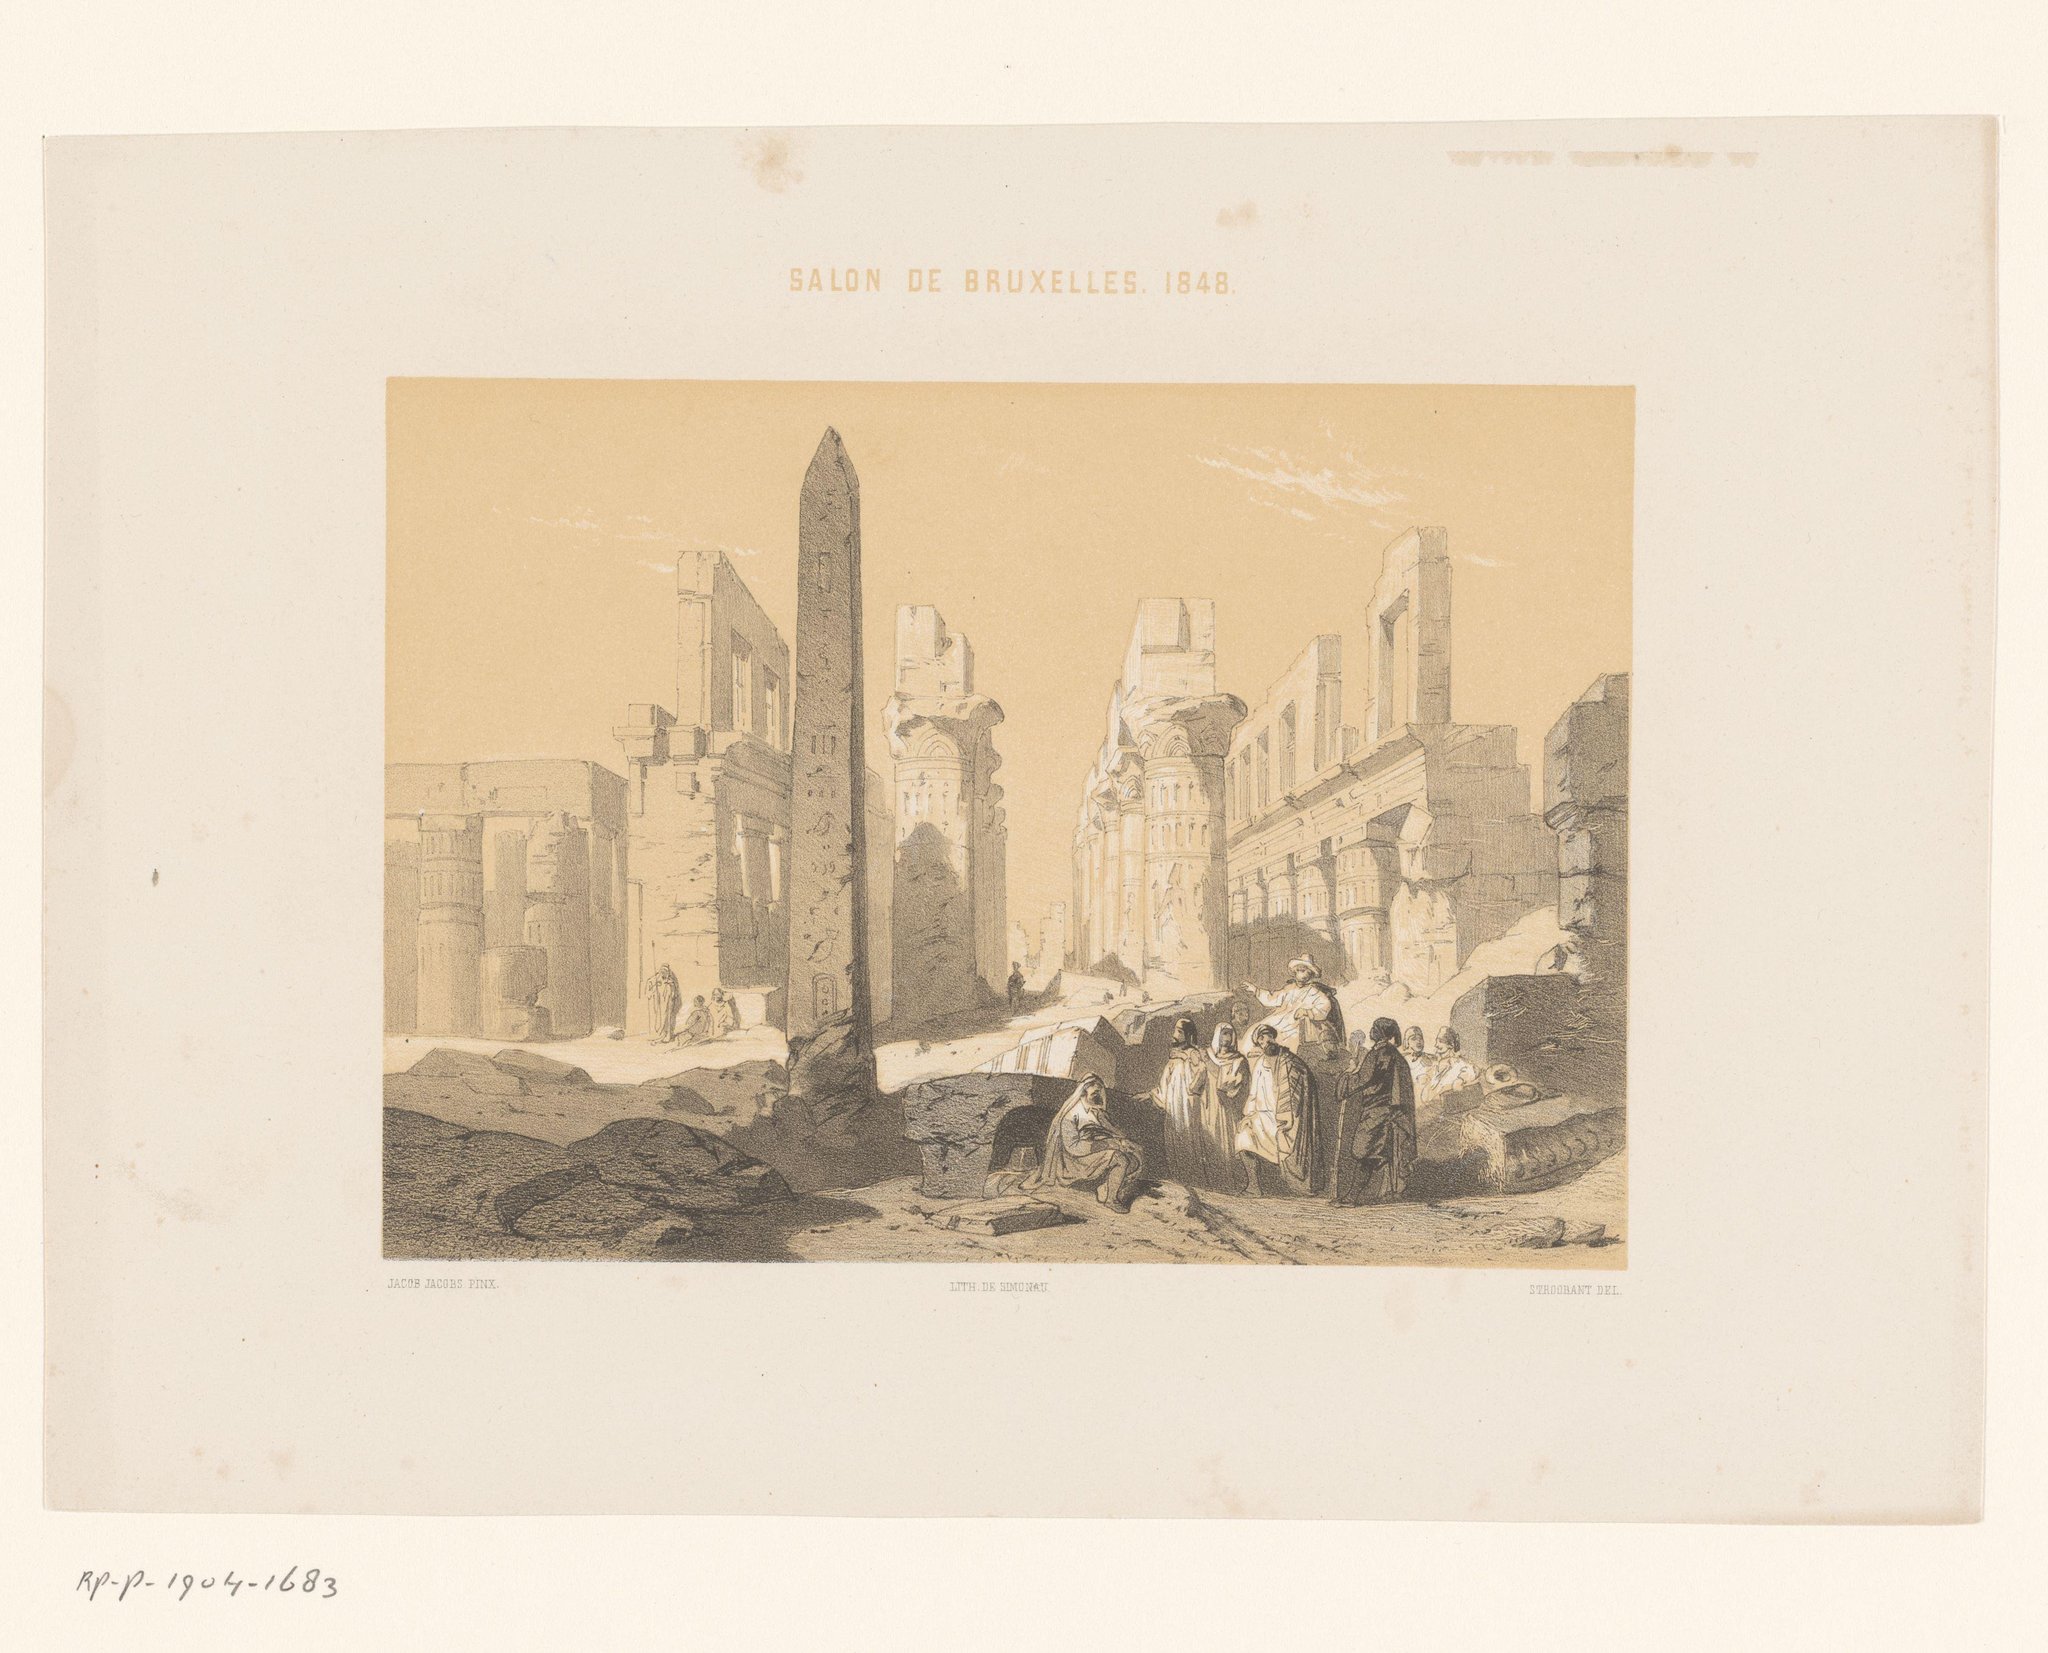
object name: print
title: Man in een draagstoel bezoekt Egyptische ruïnes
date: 1848-1904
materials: paper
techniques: tone lithography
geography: brussels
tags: obelisk, needle, (carrying a person in a) sedan-chair, landscape with ruins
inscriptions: collector's mark: Lugt 2228